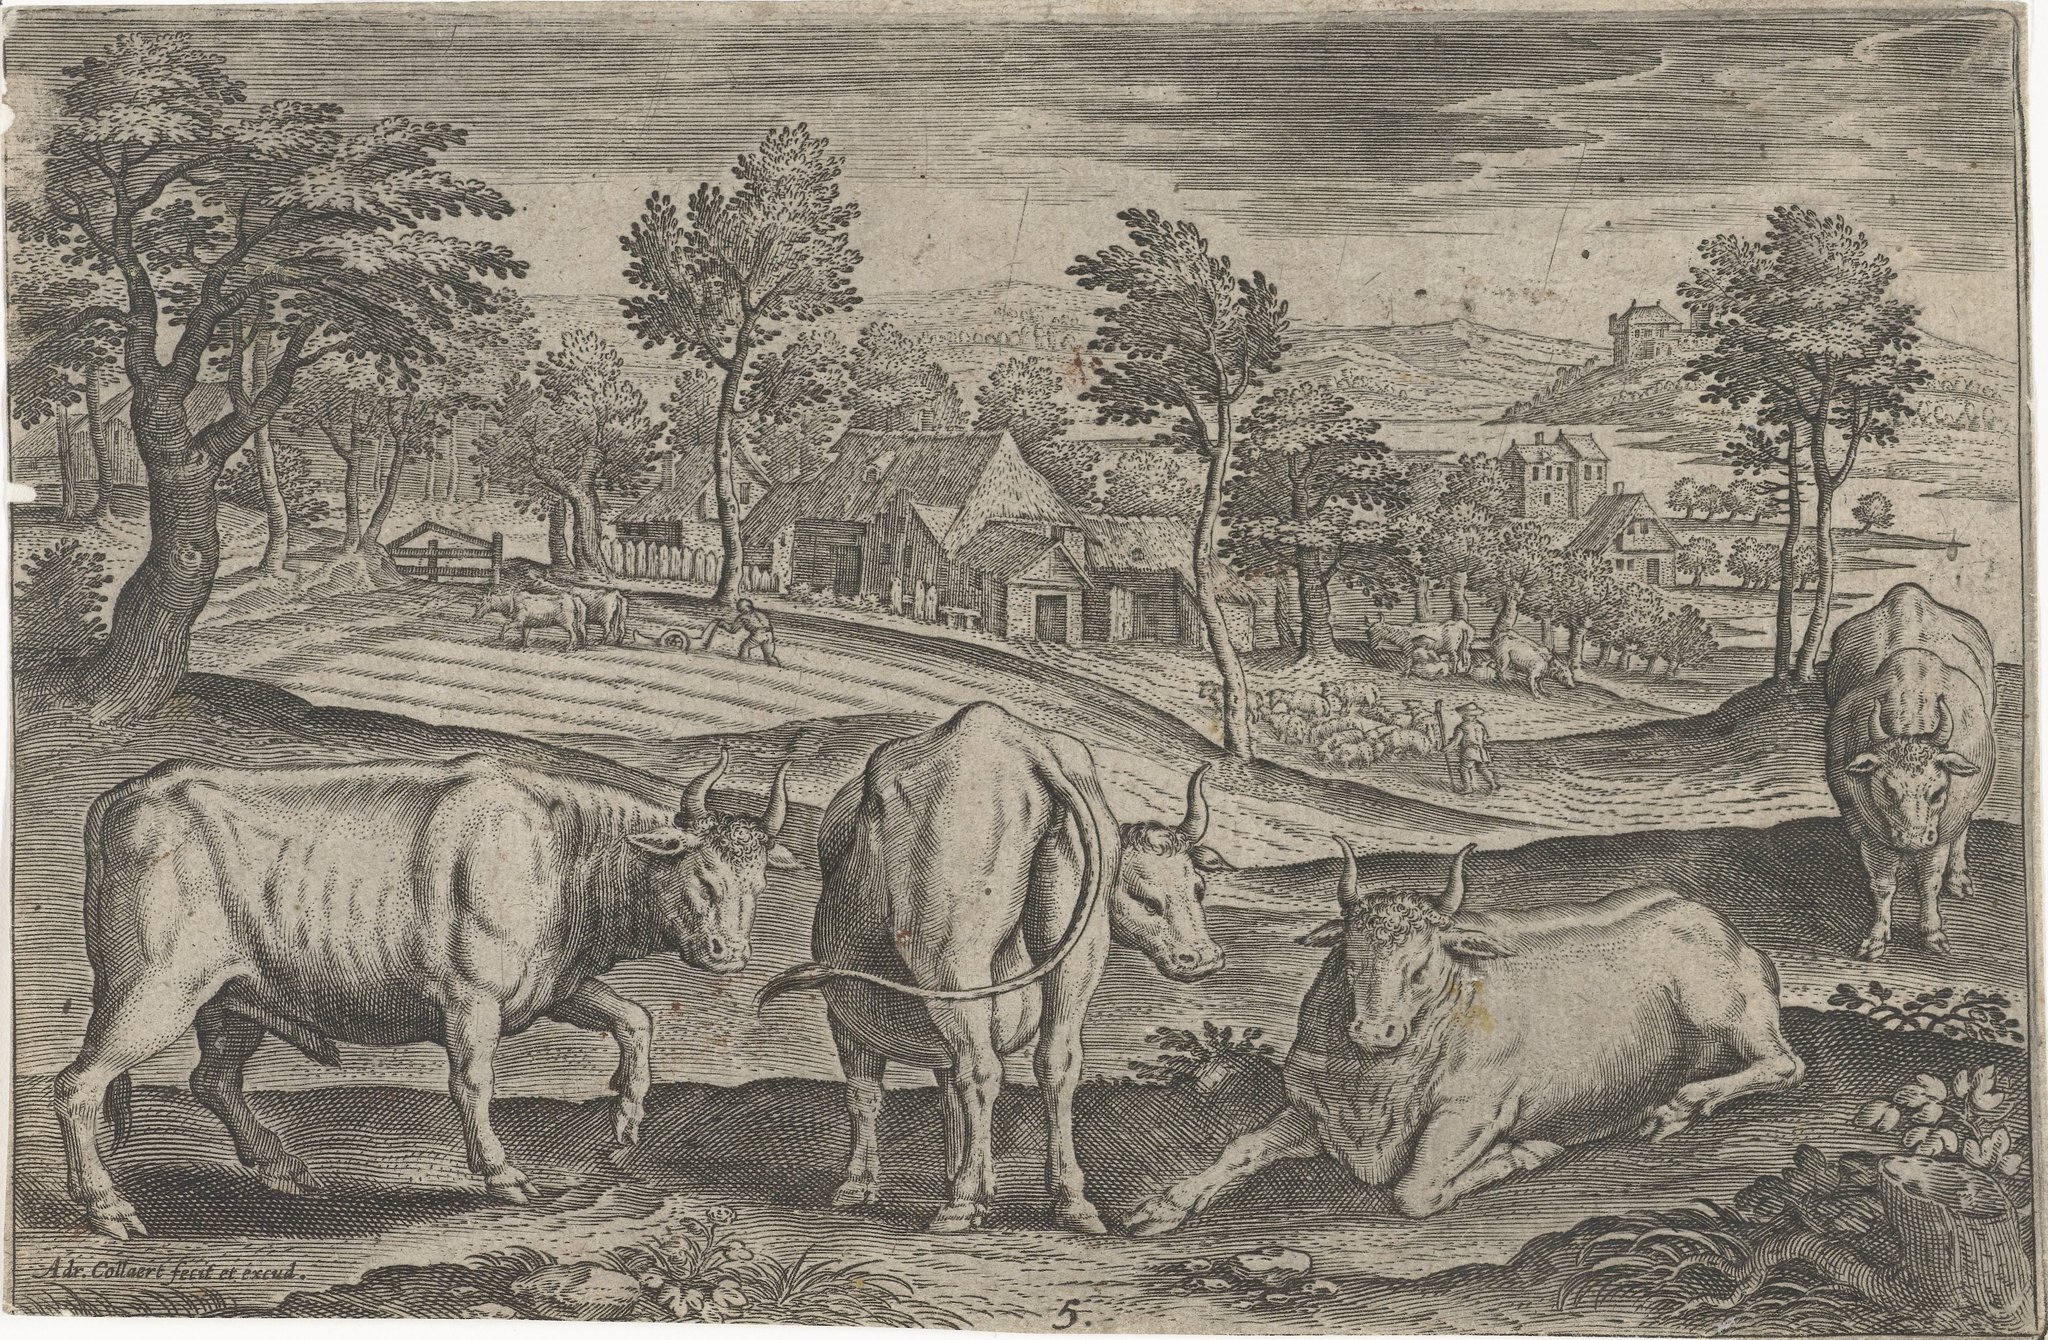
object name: print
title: Animalivm Qvaddrvpedvm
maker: adriaen collaert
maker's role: draughtsman, print maker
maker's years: 1560-1618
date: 1595-1597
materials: paper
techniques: engraving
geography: antwerp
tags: bull, farm or solitary house in landscape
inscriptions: collector's mark: Lugt 2760, collector's mark: Lugt 2228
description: Op de voorgrond vier stieren. Op de achtergrond een landschap met een boerderij. De prent maakt deel uit van een serie met dieren als onderwerp.